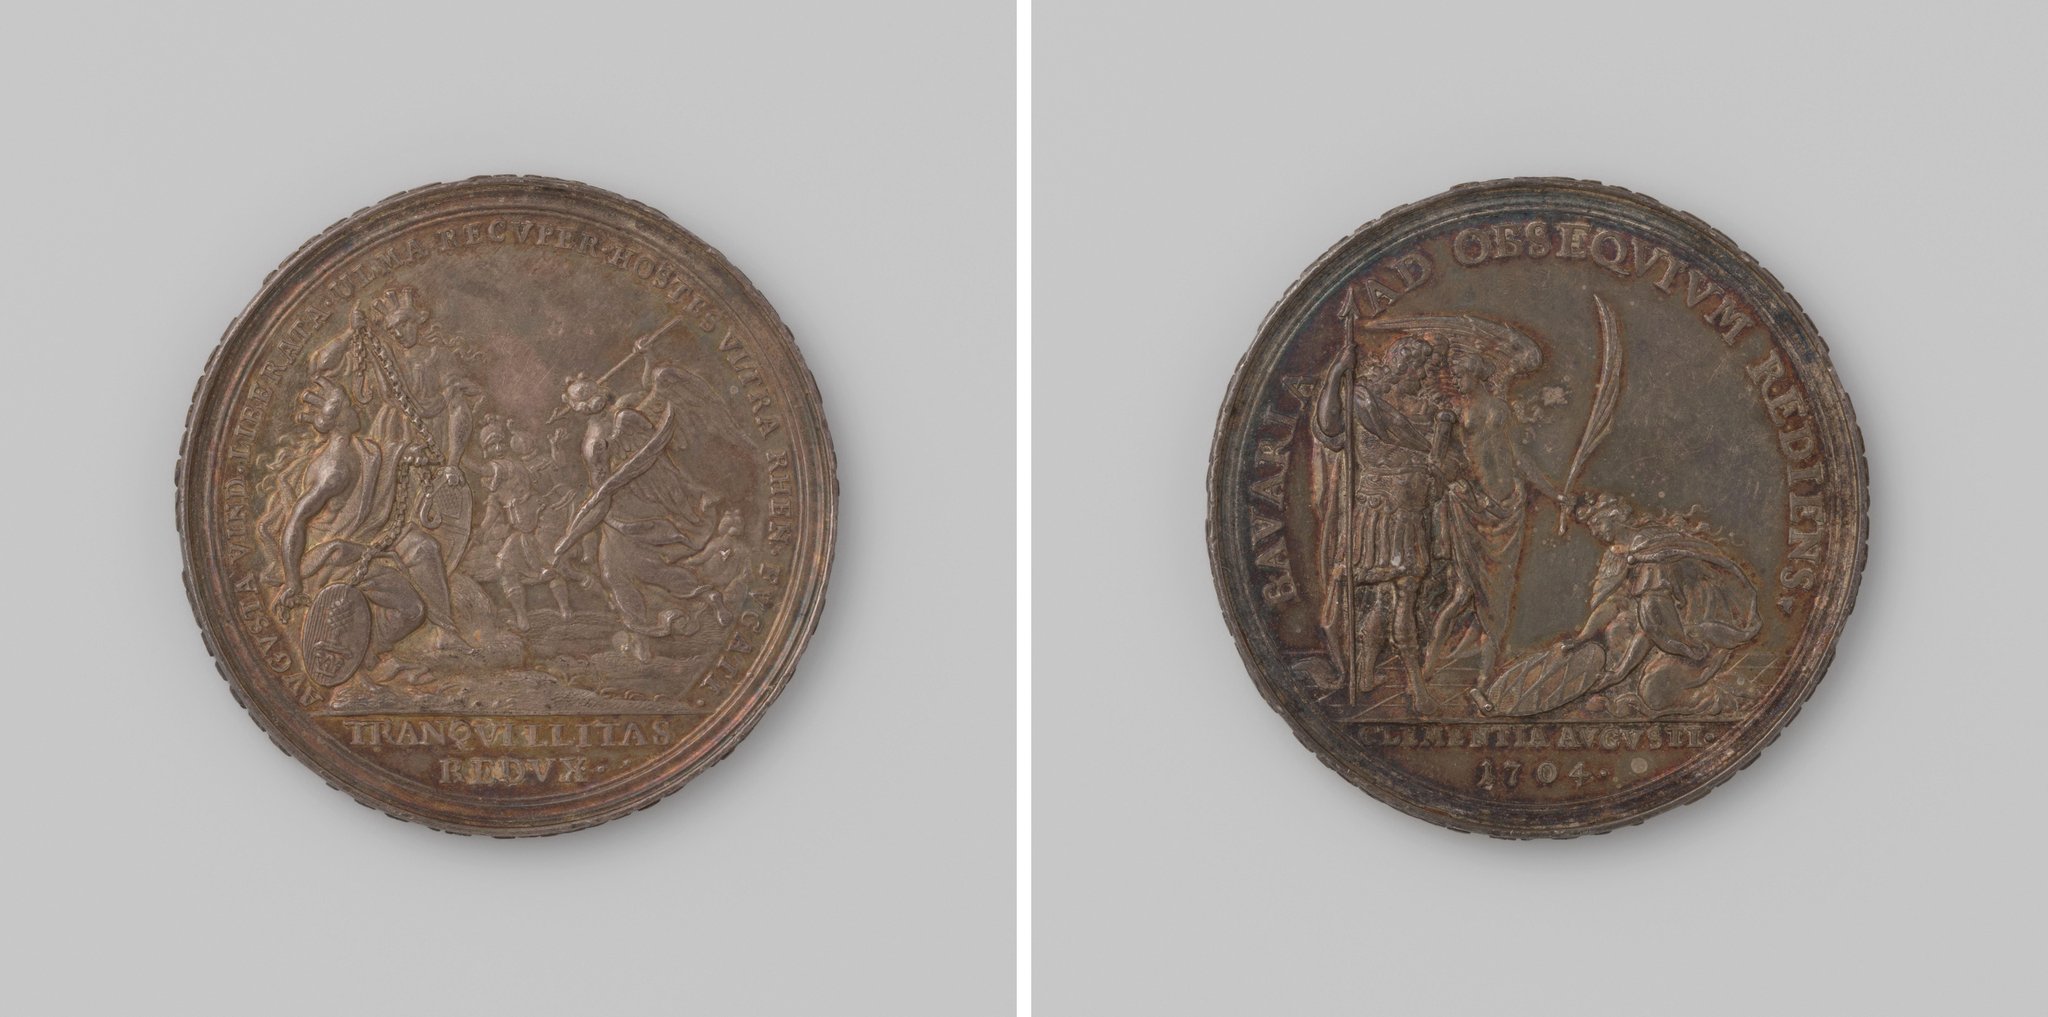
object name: history medal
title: Beieren onderwerpt zich aan keizer Leopold I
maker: friedrich kleinert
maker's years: 1633-1714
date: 1704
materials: silver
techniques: striking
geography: nuremberg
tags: leopold i (keizer van duitsland), augsburg